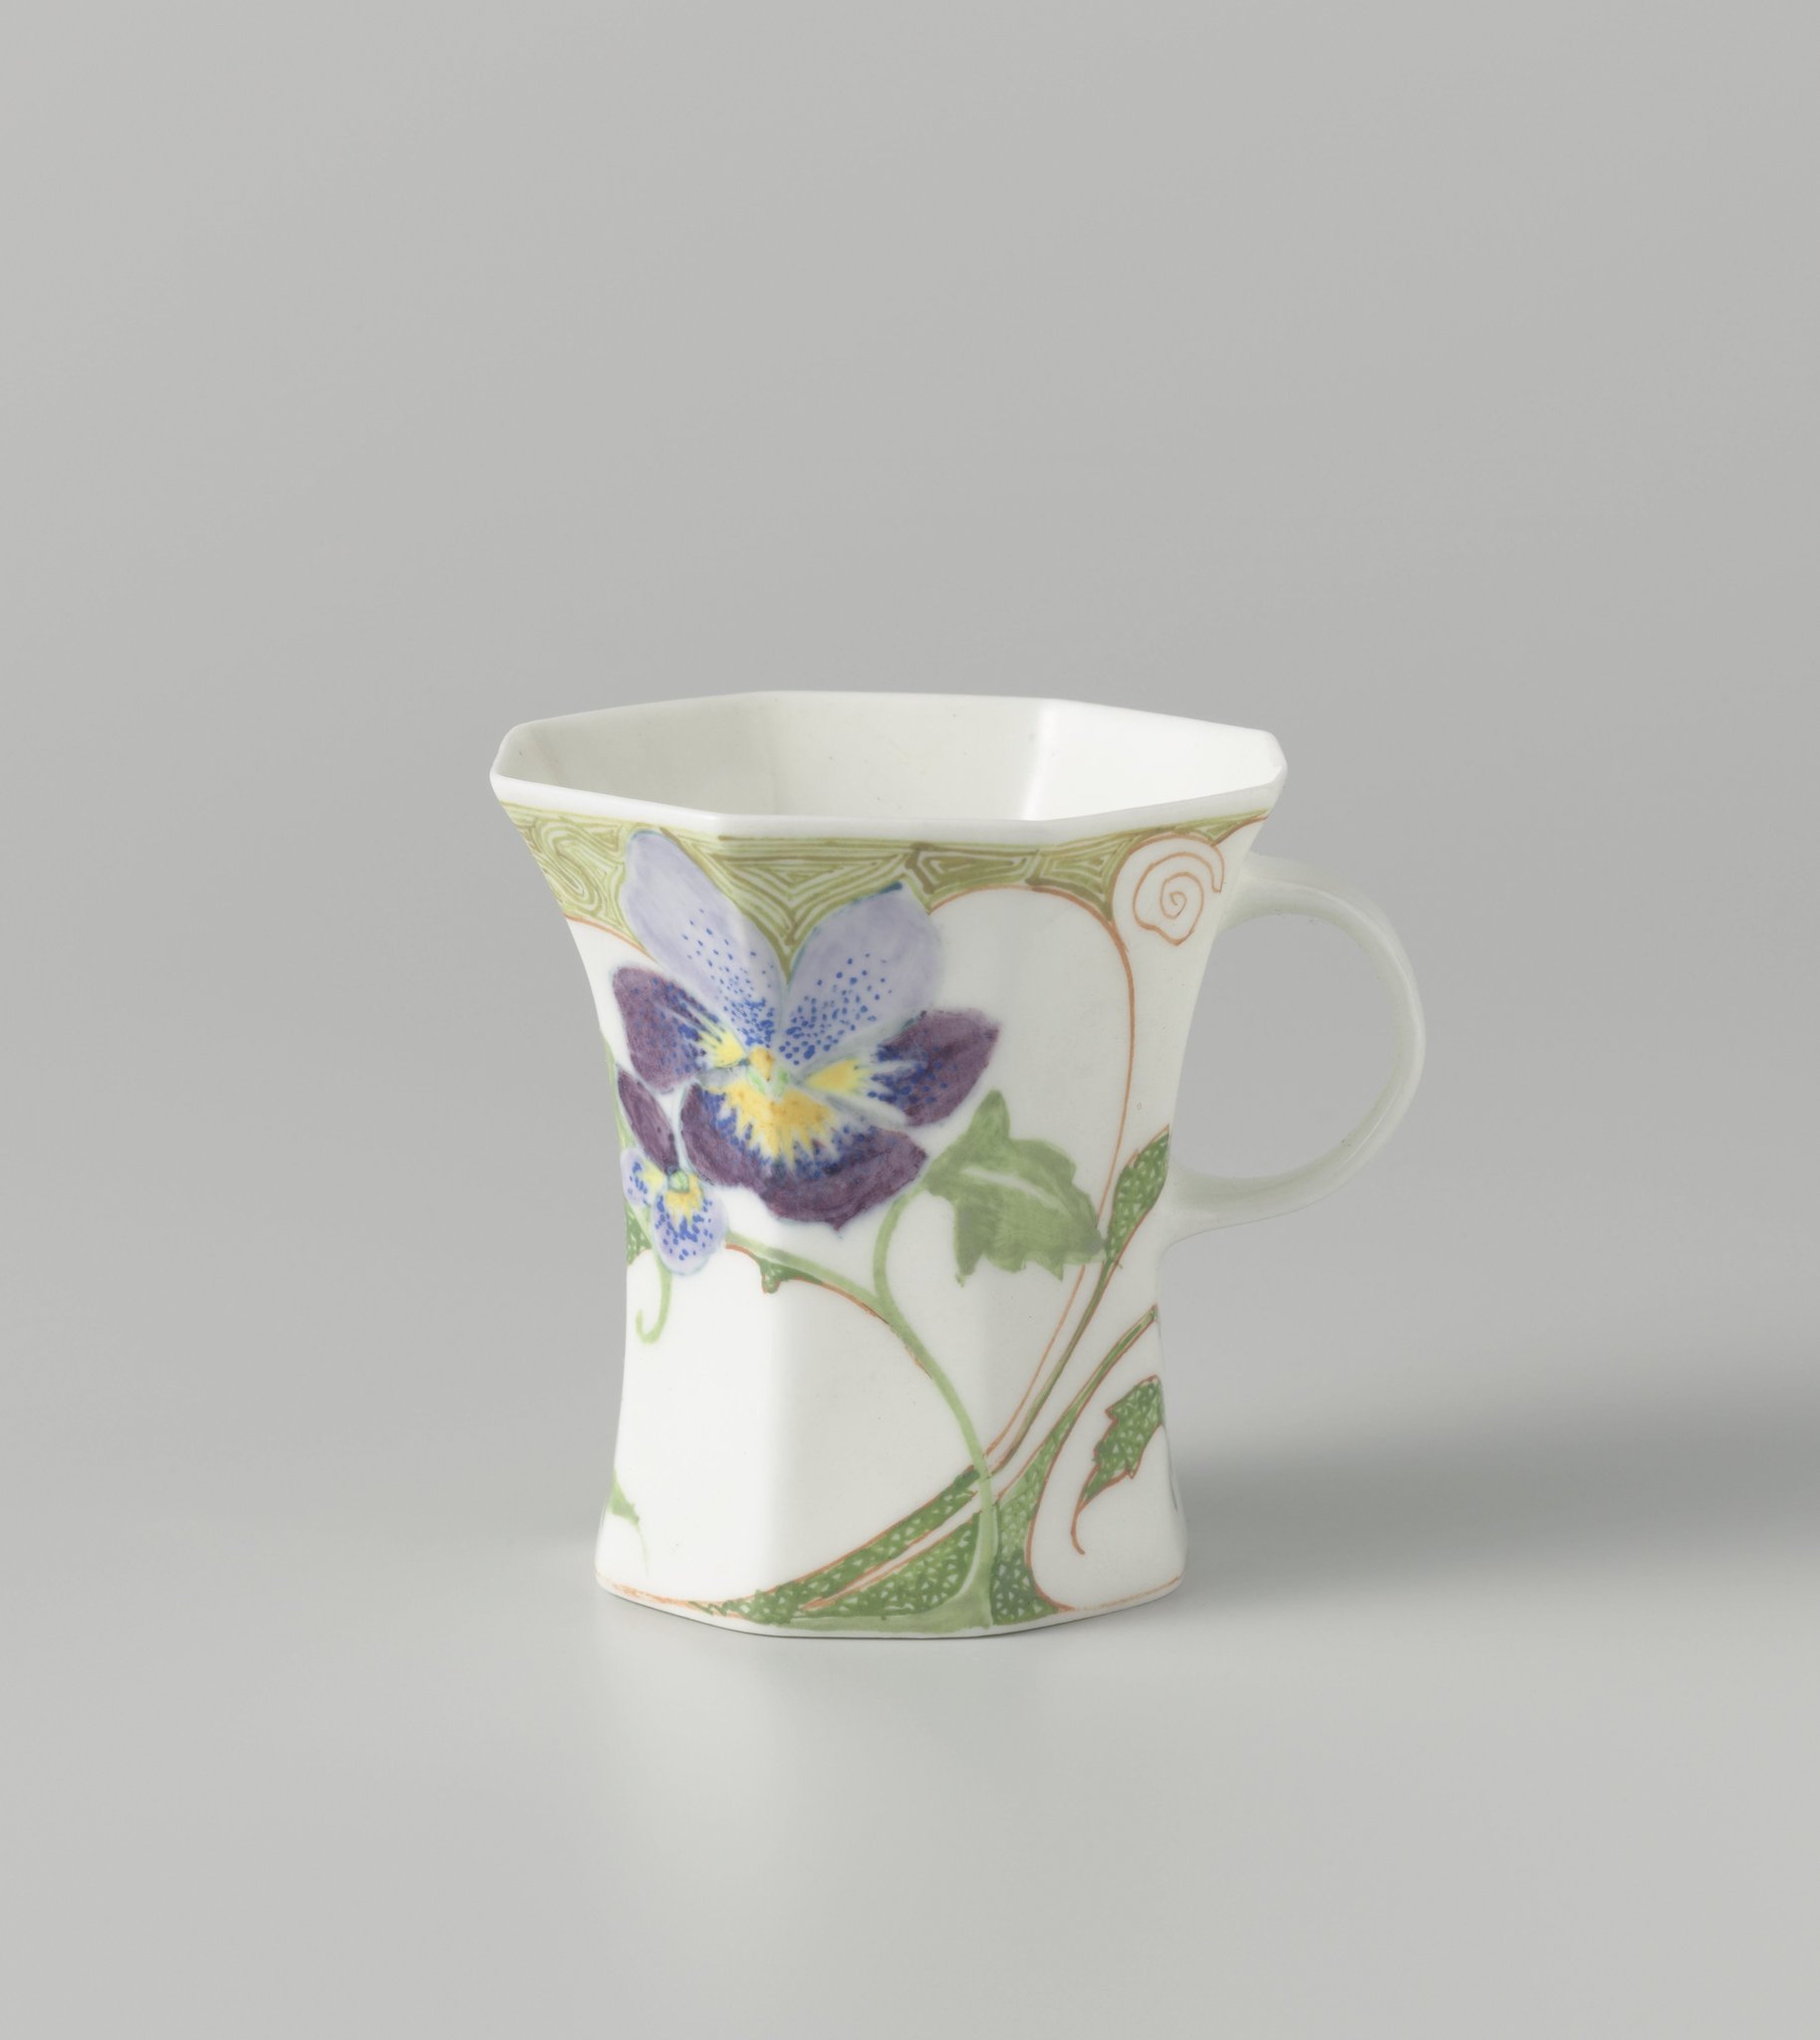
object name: cup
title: Kop, deel van een servies, beschilderd met violen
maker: c.w.j. t hart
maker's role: plateelschilder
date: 1913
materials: porcelain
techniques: painted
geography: the hague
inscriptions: mark: ‘kroon, Rozenburg, ooievaar, den Haag (boven elkaar); links het merk voor 1913, rechts het werkordernummer 332 (op een kop 333); onder het schildersmerk van C.W.J. 't Hart.’